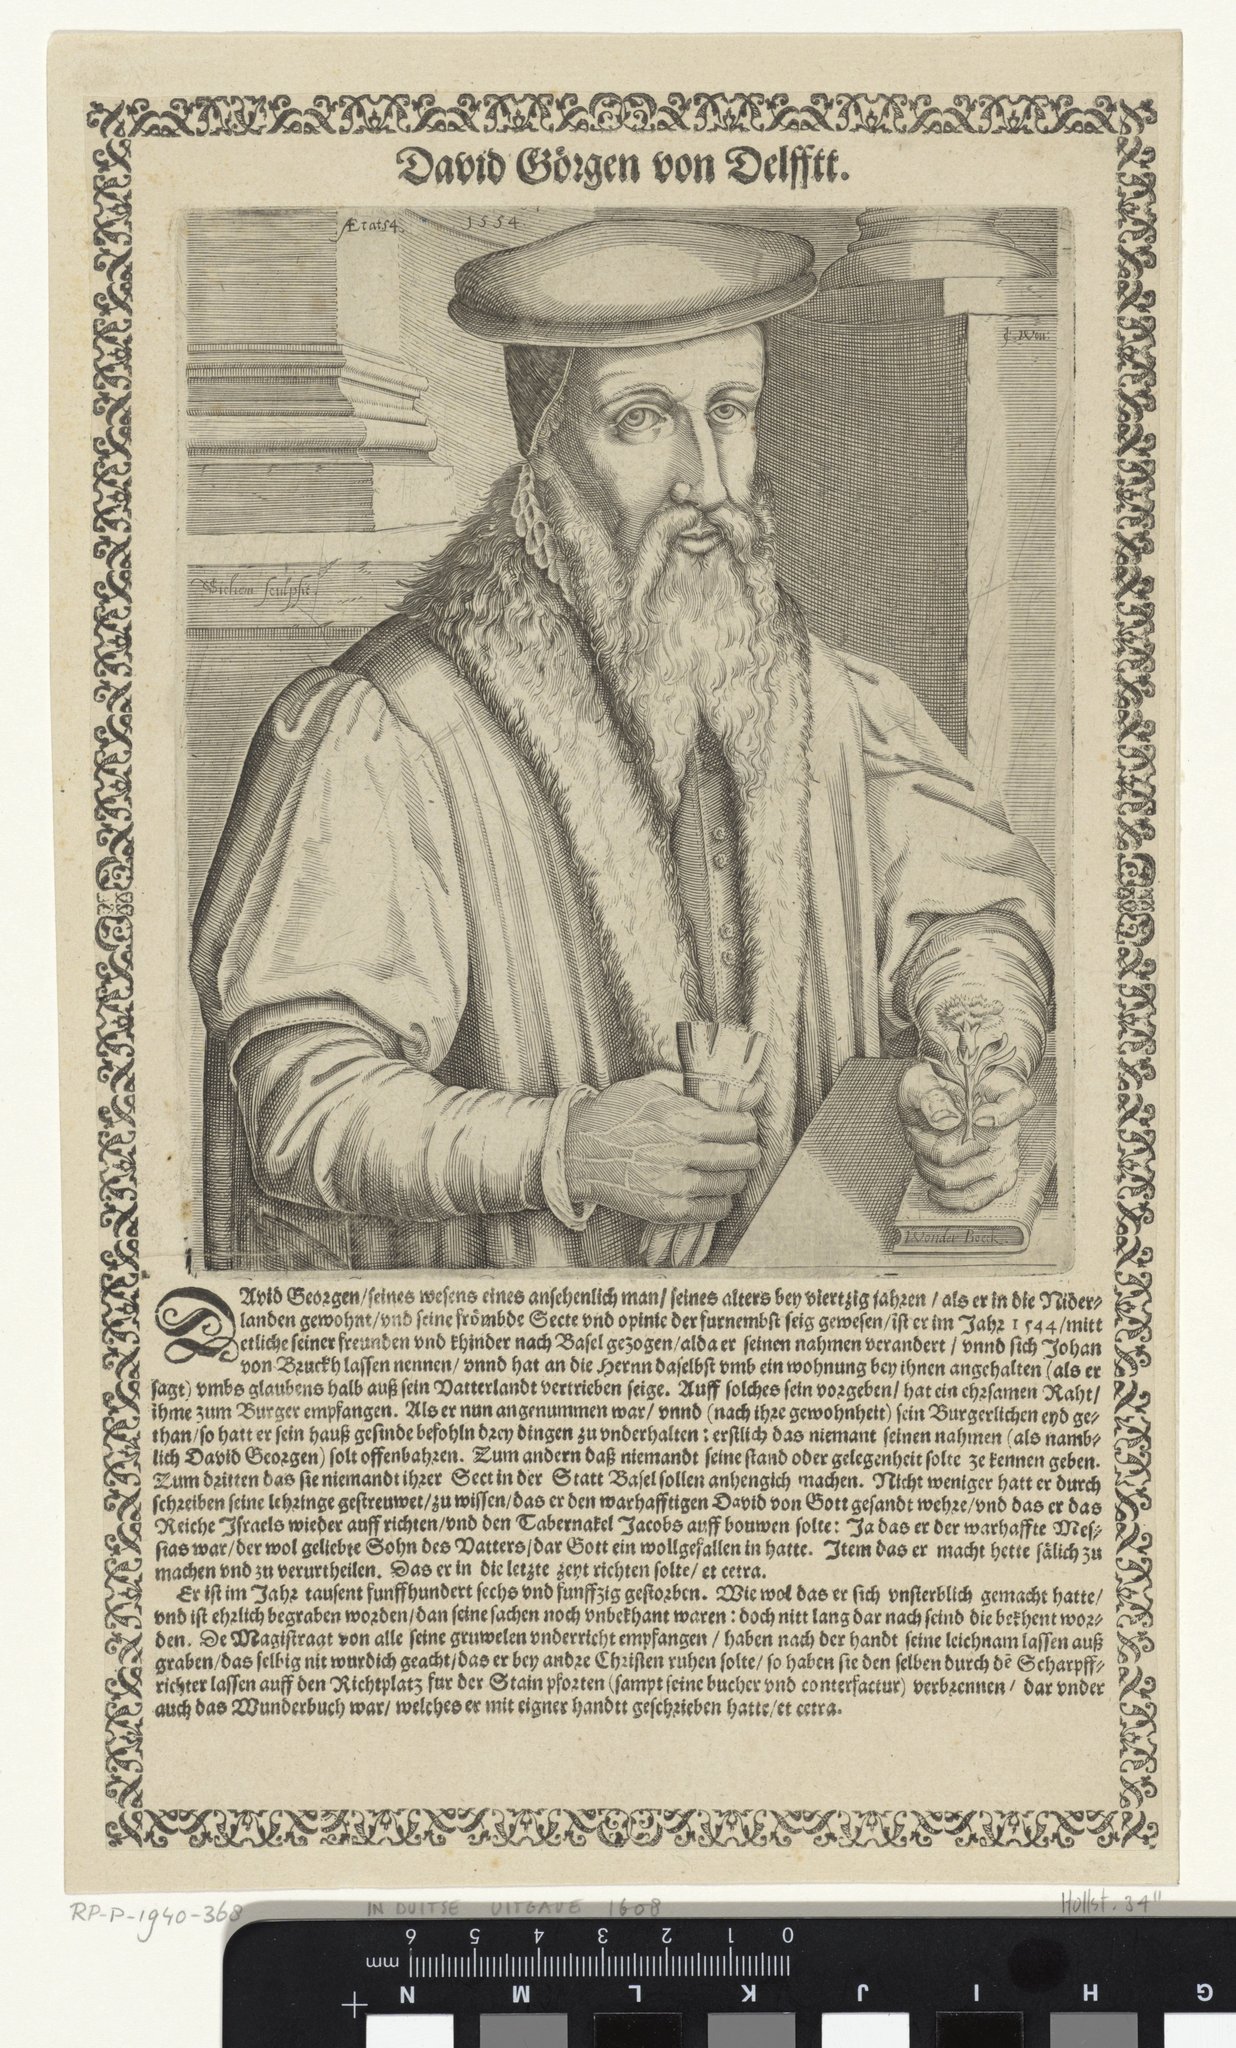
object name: print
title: Portret van David Jorisz.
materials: paper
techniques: engraving, etching, letterpress printing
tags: bruges, david jorisz.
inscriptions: collector's mark: Lugt 2228, collector's mark: Lugt 2760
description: Portret van David Jorisz., aan een tafel, waarop een exemplaar van het door hem geschreven 'Wonderboeck' ligt. Hij laat zijn hand, waarin hij een anjer vasthoudt, rusten op het boek. In de andere hand heeft hij een handschoen. Boven zijn hoofd staat het jaartal 1554 en zijn leeftijd vermeld. Onder en boven de prent Duitstalige tekst in boekdruk met een ornamentele omlijsting.